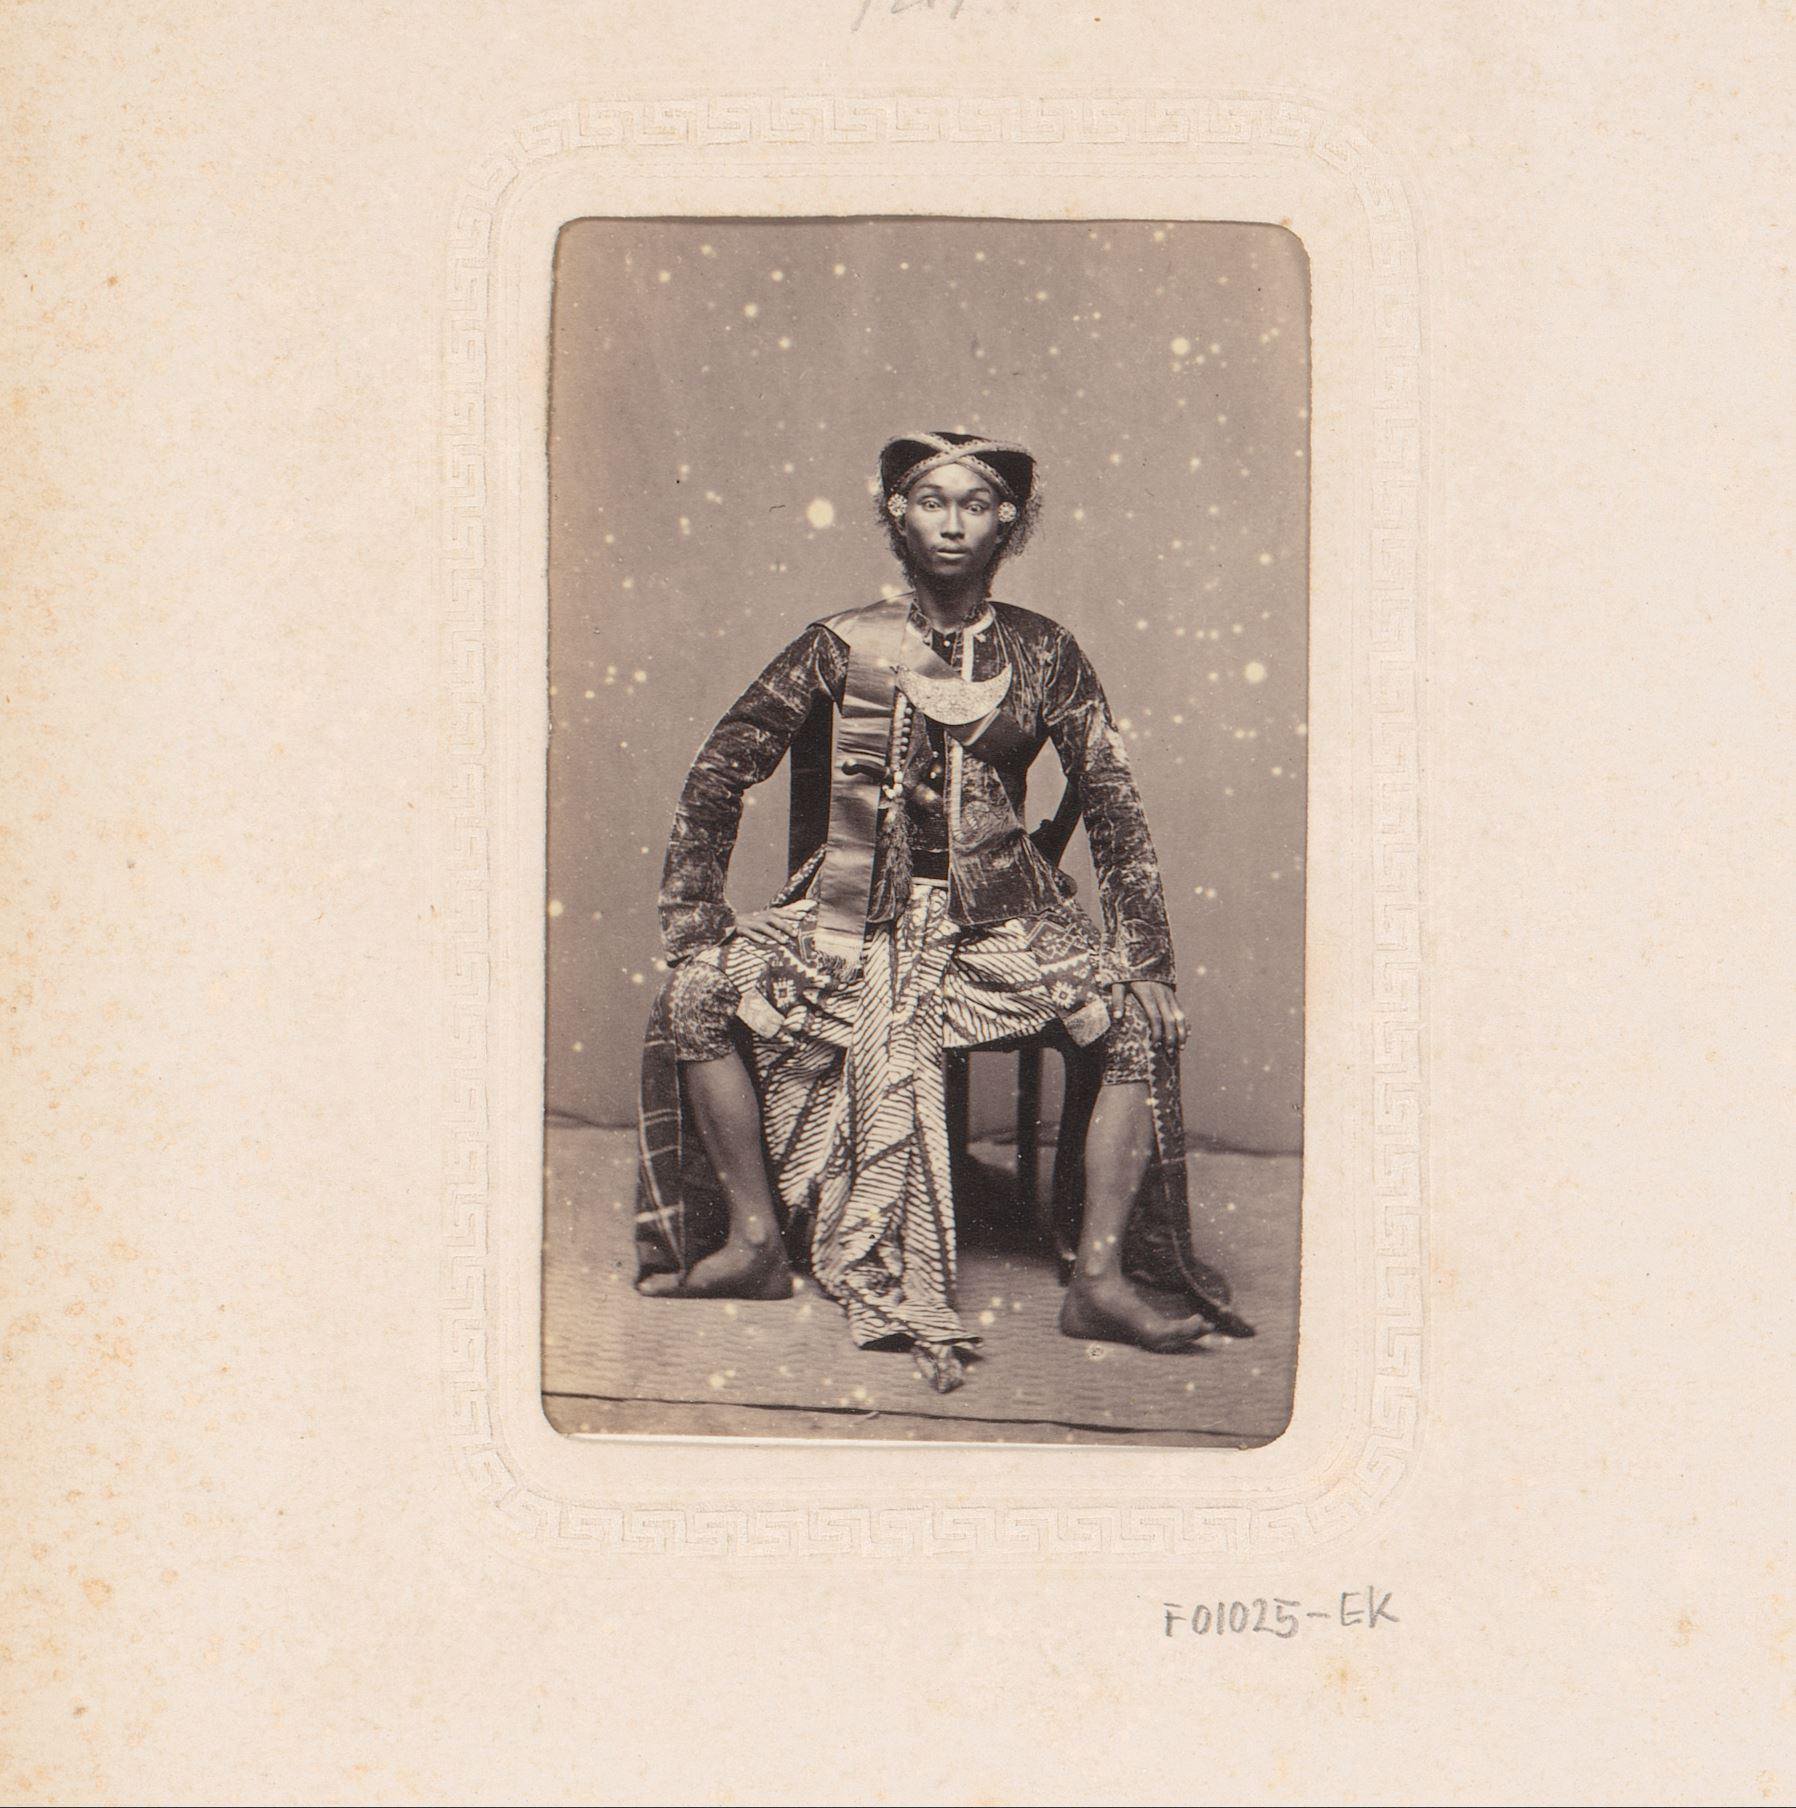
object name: album leaf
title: Portret van een Indonesische man in traditionele kleding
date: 1857-1865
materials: cardboard, photographic support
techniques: albumen print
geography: java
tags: historical persons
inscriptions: inscription: ‘Woodbury & Page/ Photographers/ Java’, number: ‘141’